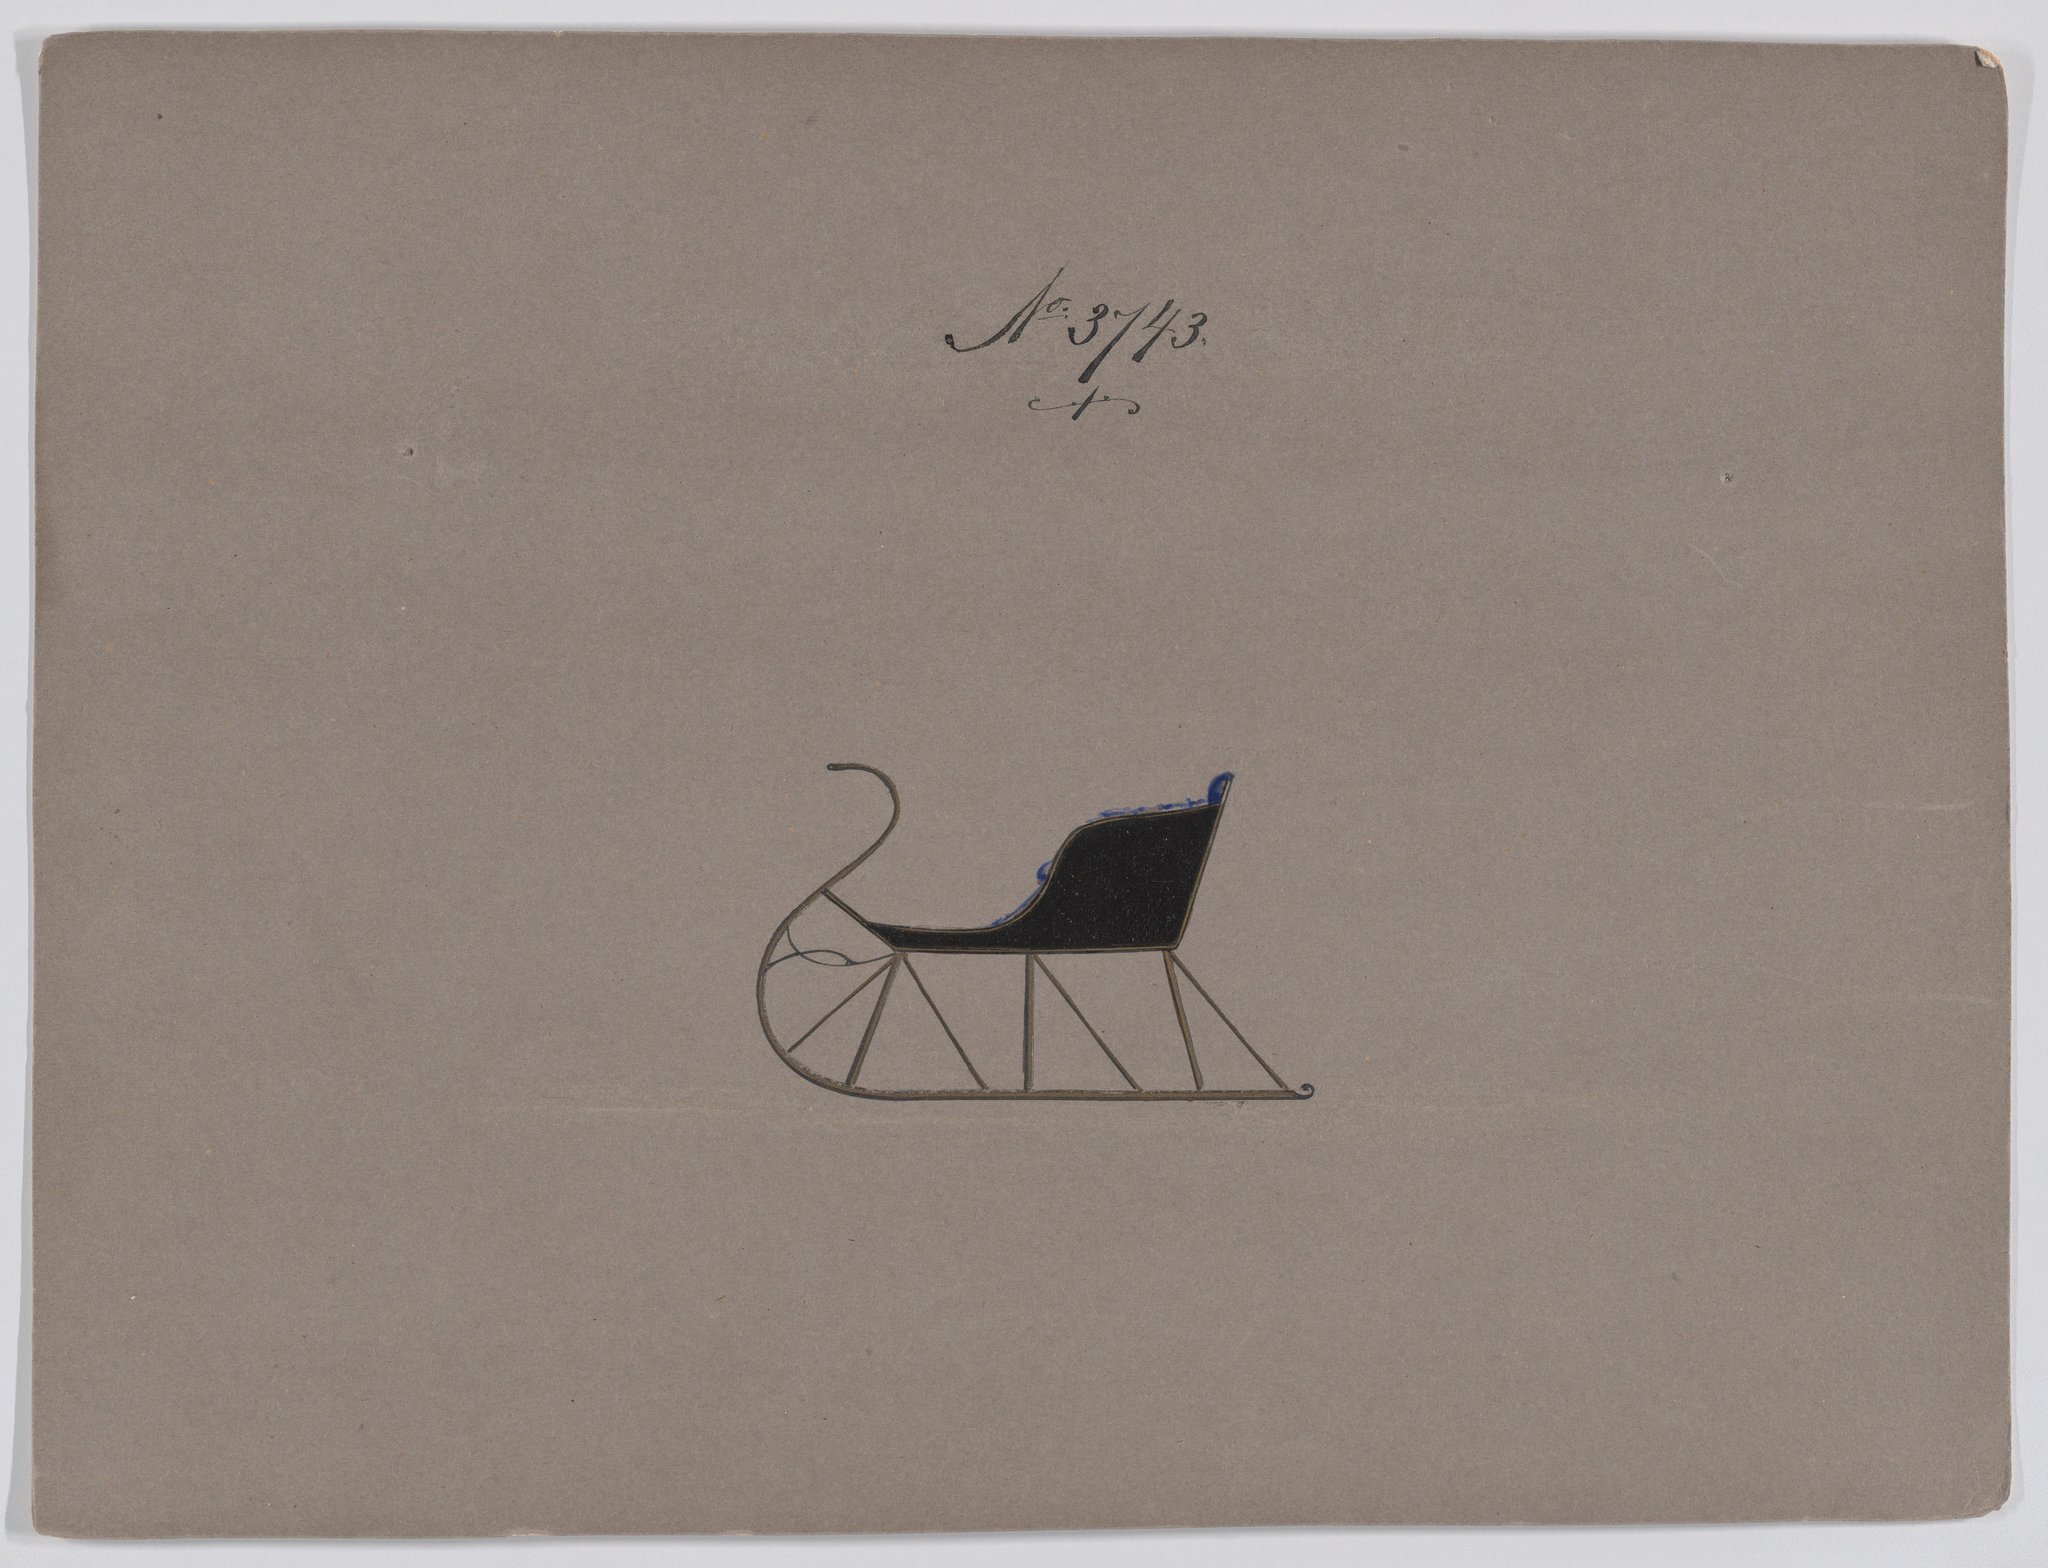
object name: drawing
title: Cutter #3743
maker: brewster & co.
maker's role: manufacturer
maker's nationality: american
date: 1882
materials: gouache, gum arabic, ink, watercolor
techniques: pen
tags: sleighs